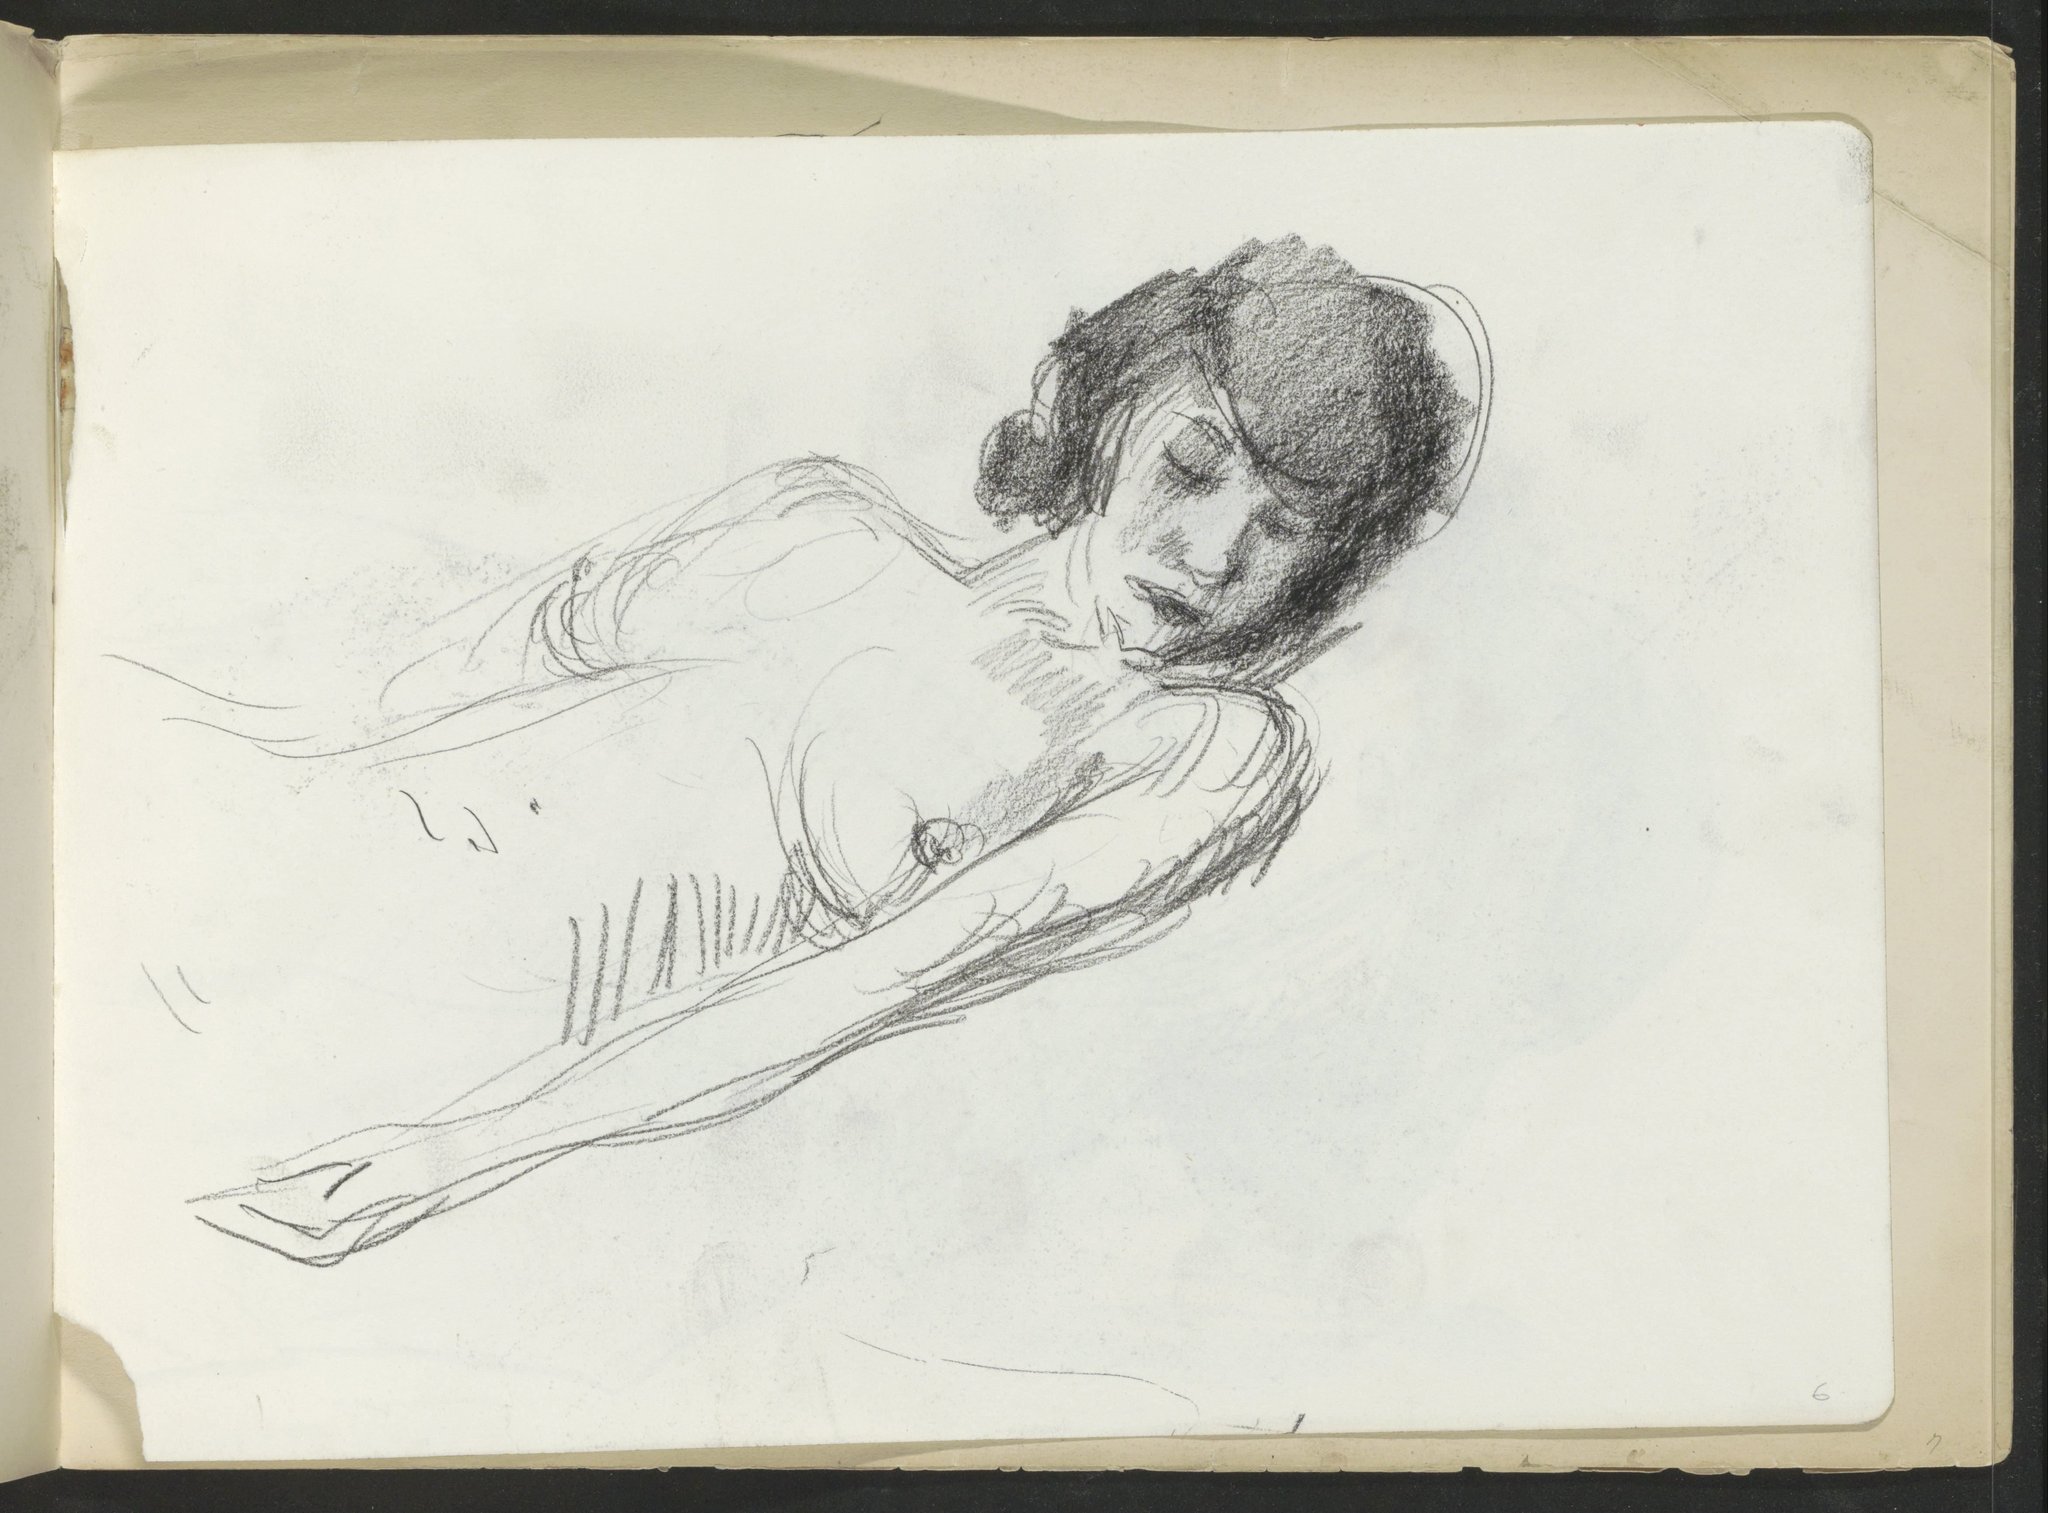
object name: sketchbook leaf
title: Liggend vrouwelijk naakt, slapend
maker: isaac israels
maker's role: draughtsman, painter, print maker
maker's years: 1865-1934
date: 1886-1934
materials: chalk, paper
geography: amsterdam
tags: the (nude) human figure; 'corpo humano' (ripa) - aa - female human figure (+ lying), sleeping; unconsciousness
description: Blad 6 recto uit schetsboek LXVII met 11 bladen.